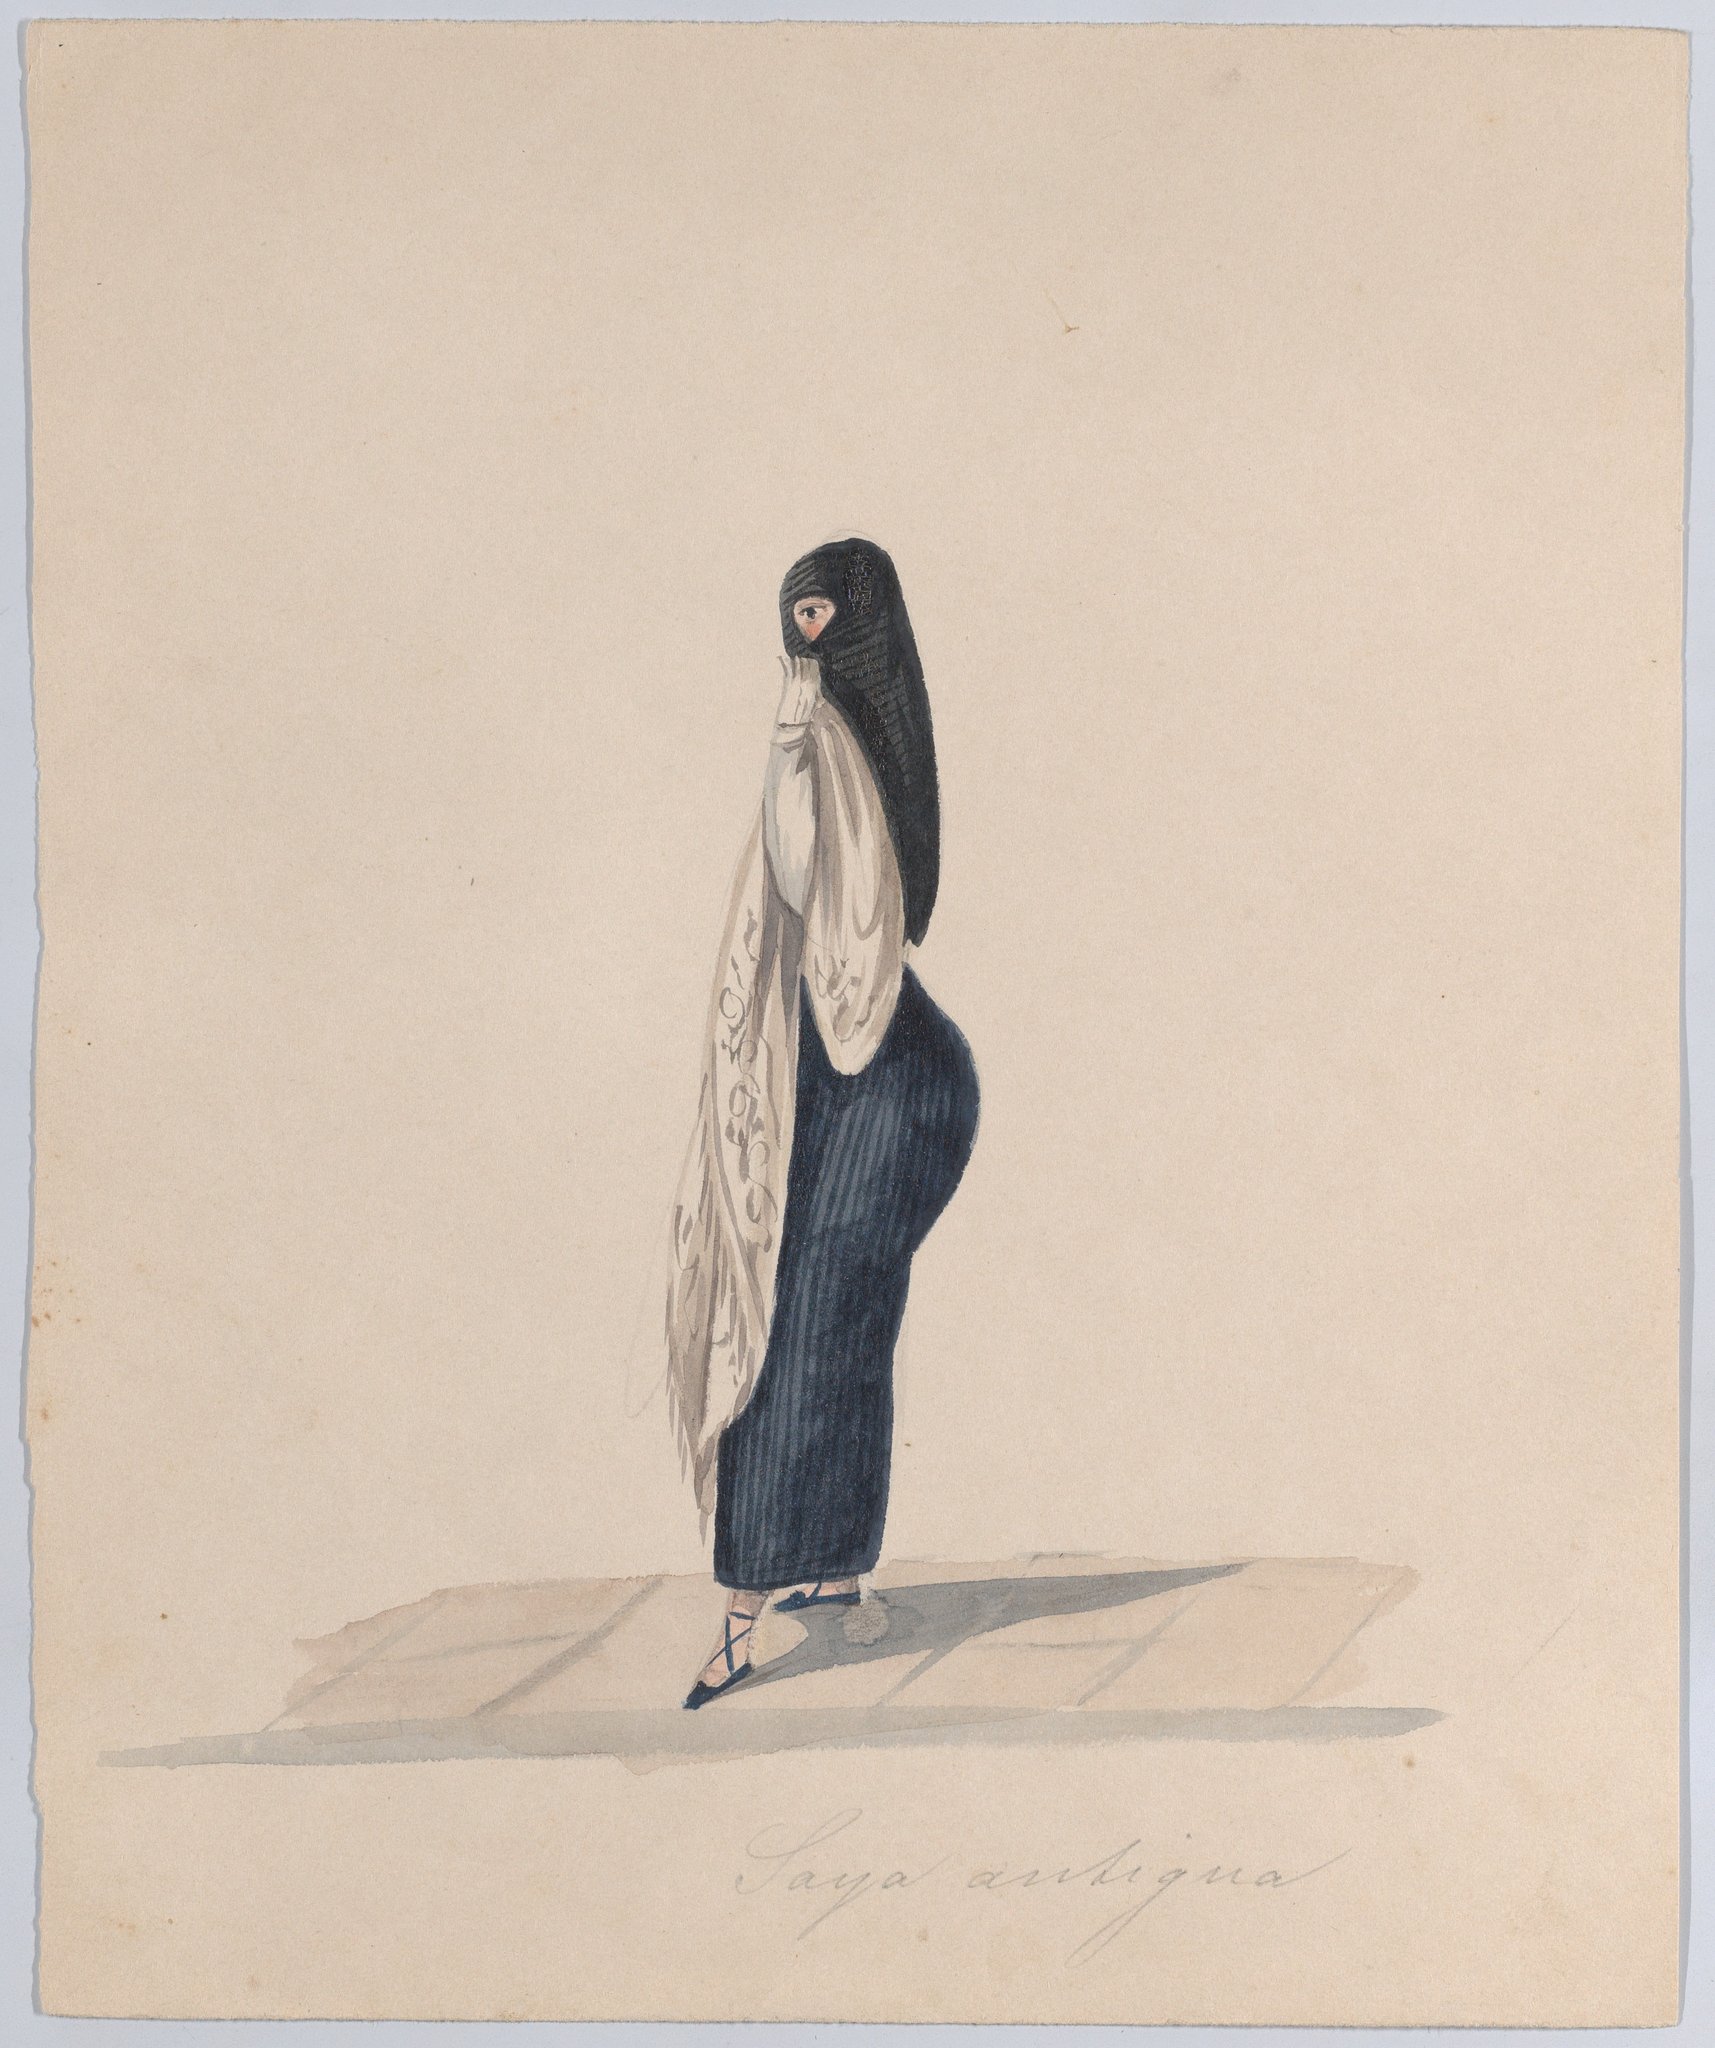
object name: drawing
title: A woman wearing the saya standing in profile, from a group of drawings depicting Peruvian dress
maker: francisco (pancho) fierro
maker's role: artist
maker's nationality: african peruvian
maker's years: 1807-1879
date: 1848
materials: watercolor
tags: women